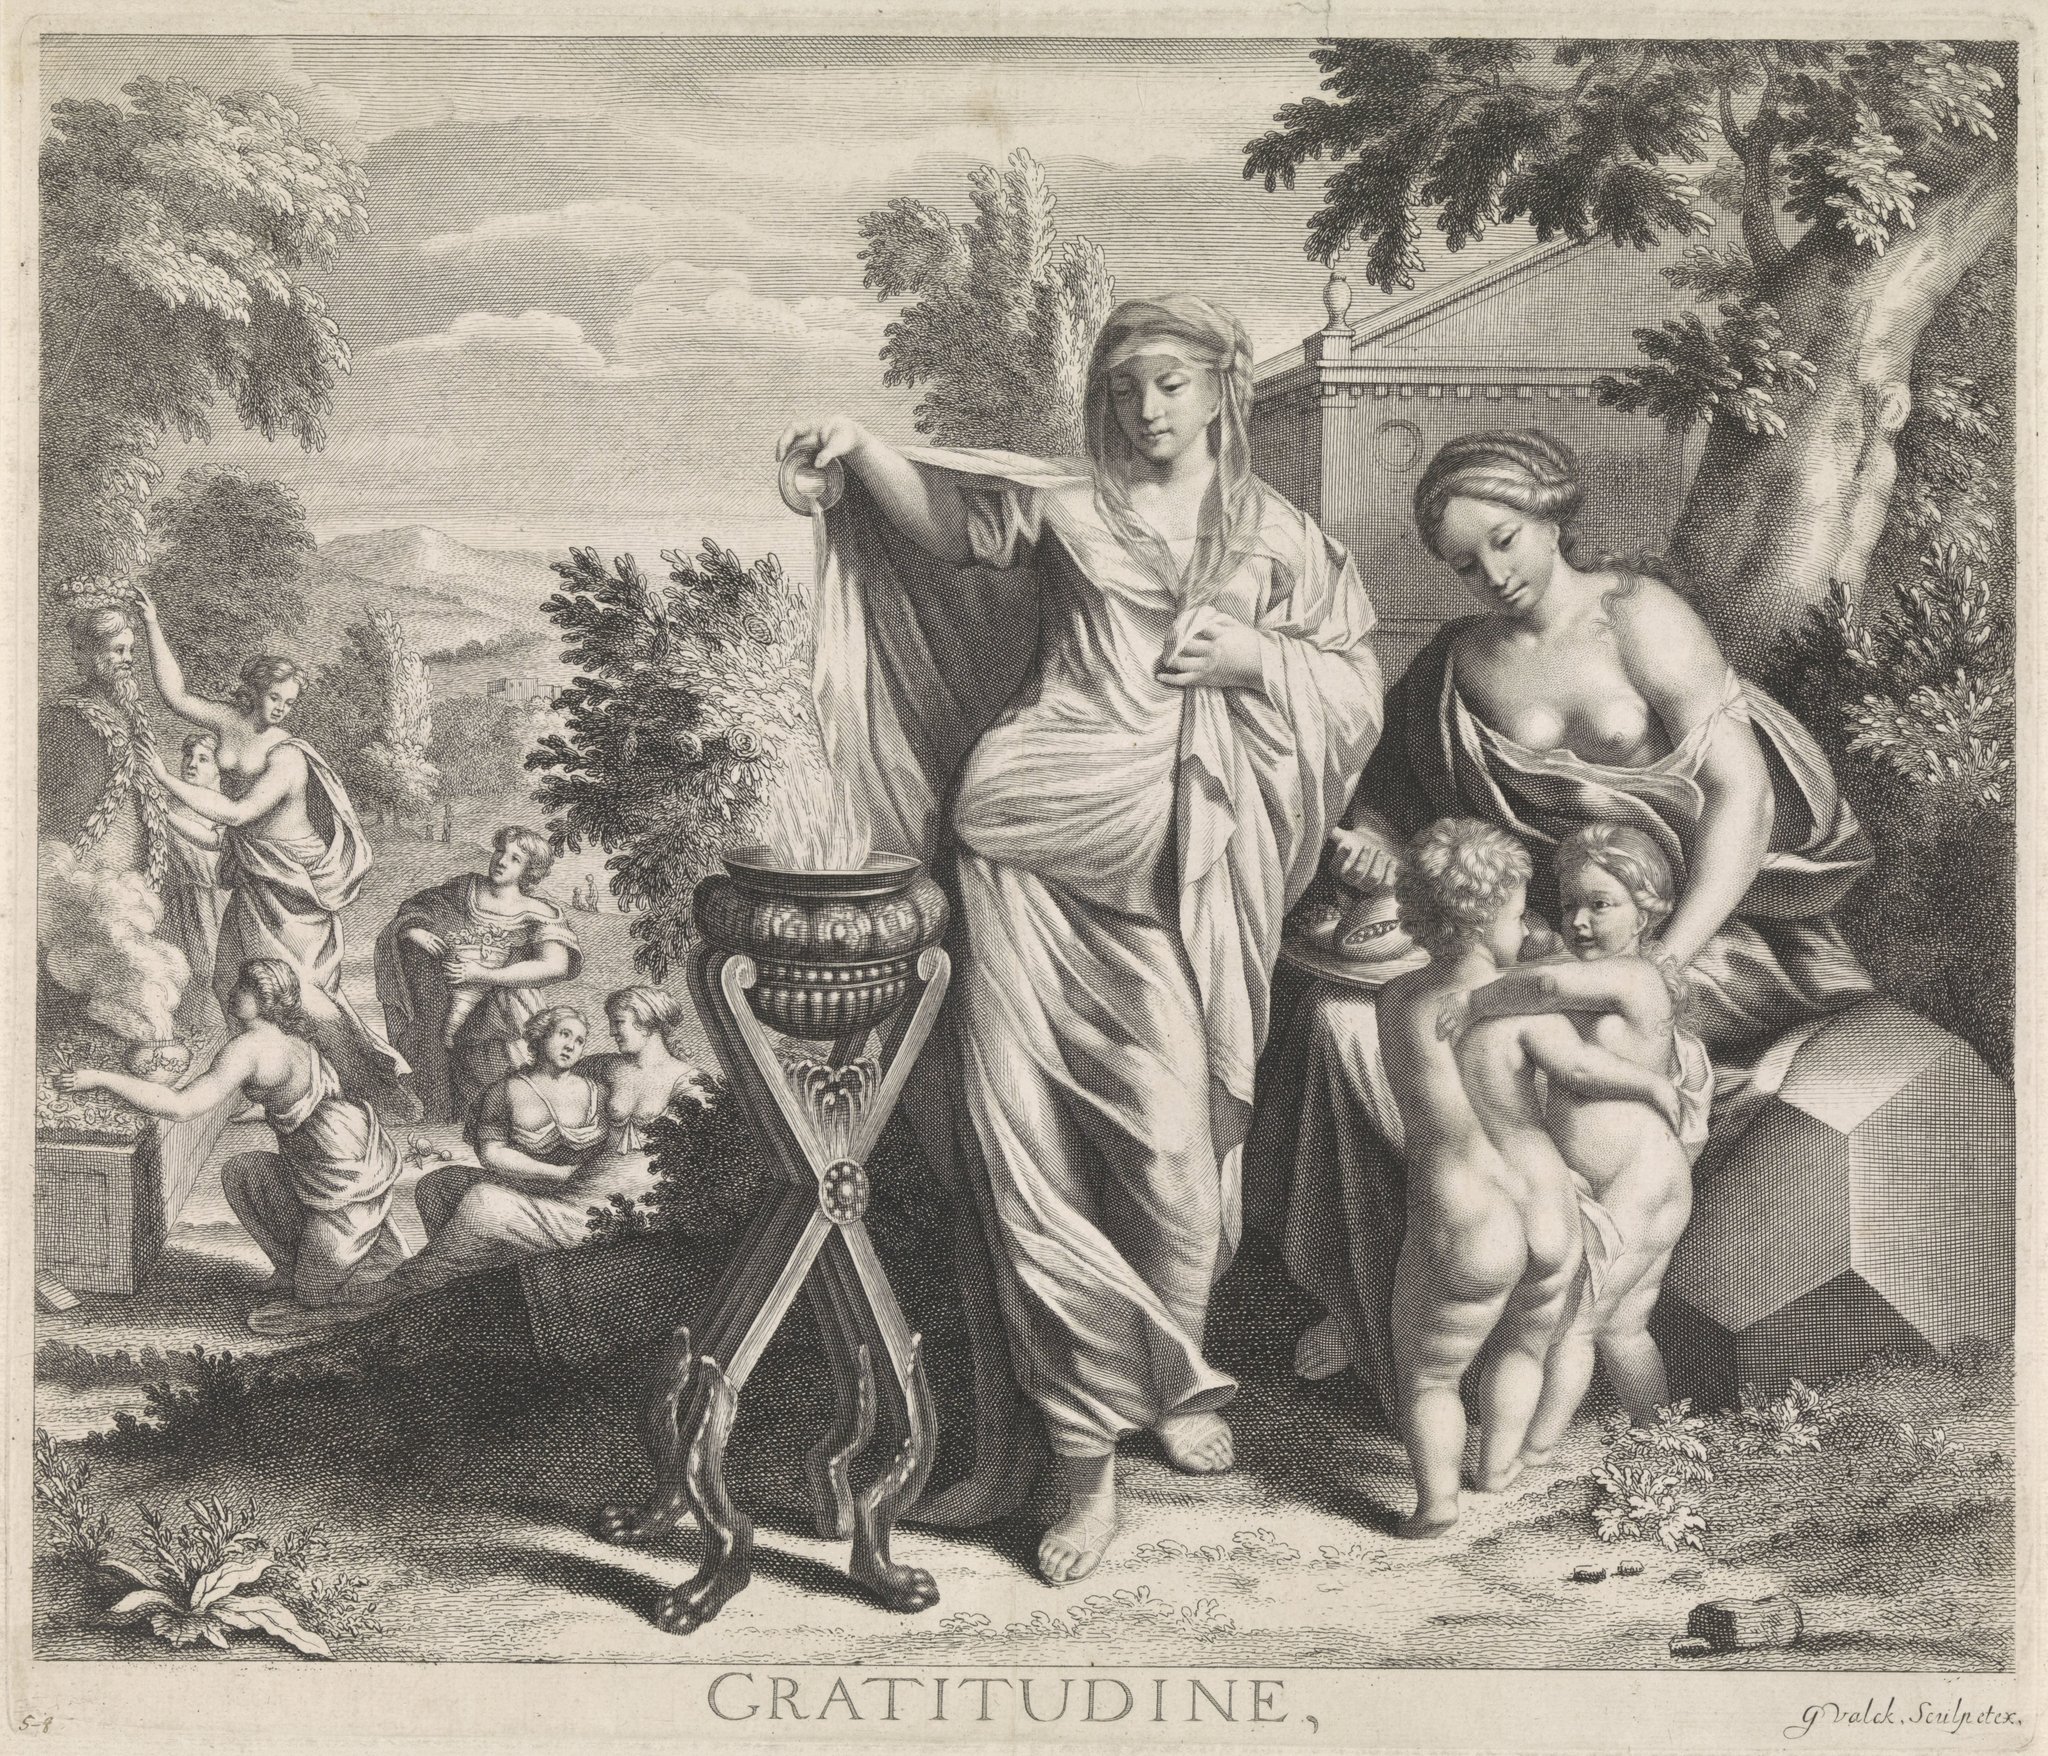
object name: print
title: Gratitudine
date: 1694-1715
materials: paper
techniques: engraving, etching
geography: amsterdam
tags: offering; 'offerta overo oblatione' (ripa), janus' head, two-faced head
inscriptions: collector's mark: Lugt 2228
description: Een vrouw brengt een offer. Rechts een vrouw en twee kinderen, links op de achtergrond offeren figuren bloemen aan een beeltenis van de godheid Janus. Dit beeld heeft aan de ene kant een kop van een oude man en aan de andere de kop van een jonge man.